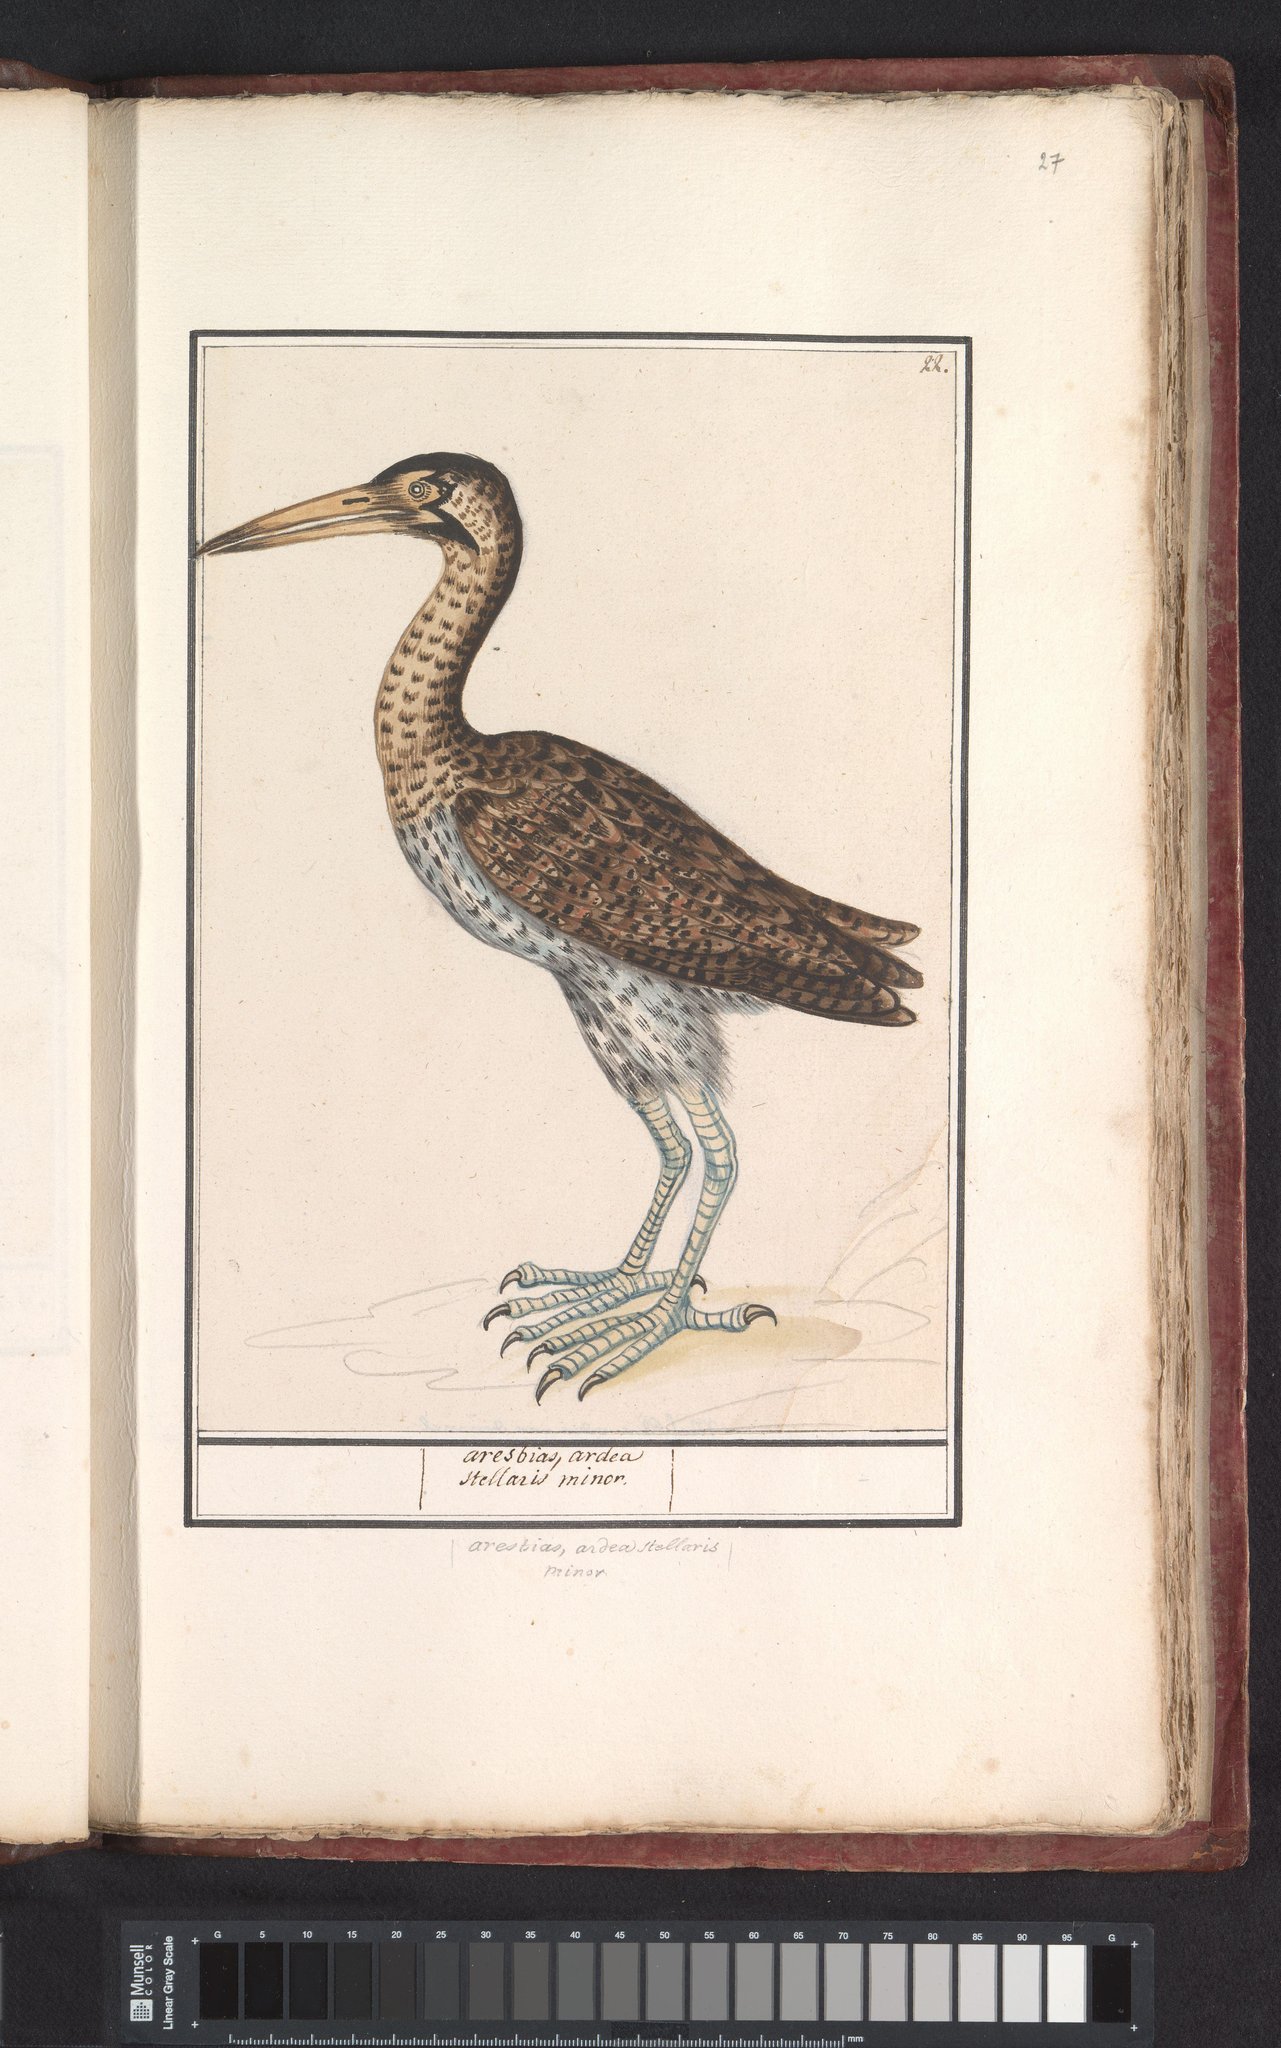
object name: drawing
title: Roerdomp (Botaurus stellaris)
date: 1596-1610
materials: chalk, paint, paper, pencil, watercolor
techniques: brush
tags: shore-birds and wading-birds: bittern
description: Roerdomp. Genummerd rechtsboven: 22. Onderdeel van het derde album met tekeningen van vogels. Vijfde van twaalf albums met tekeningen van dieren, vogels en planten bekend rond 1600, gemaakt in opdracht van keizer Rudolf II. Met toelichting in Nederlands, Latijn en Frans.